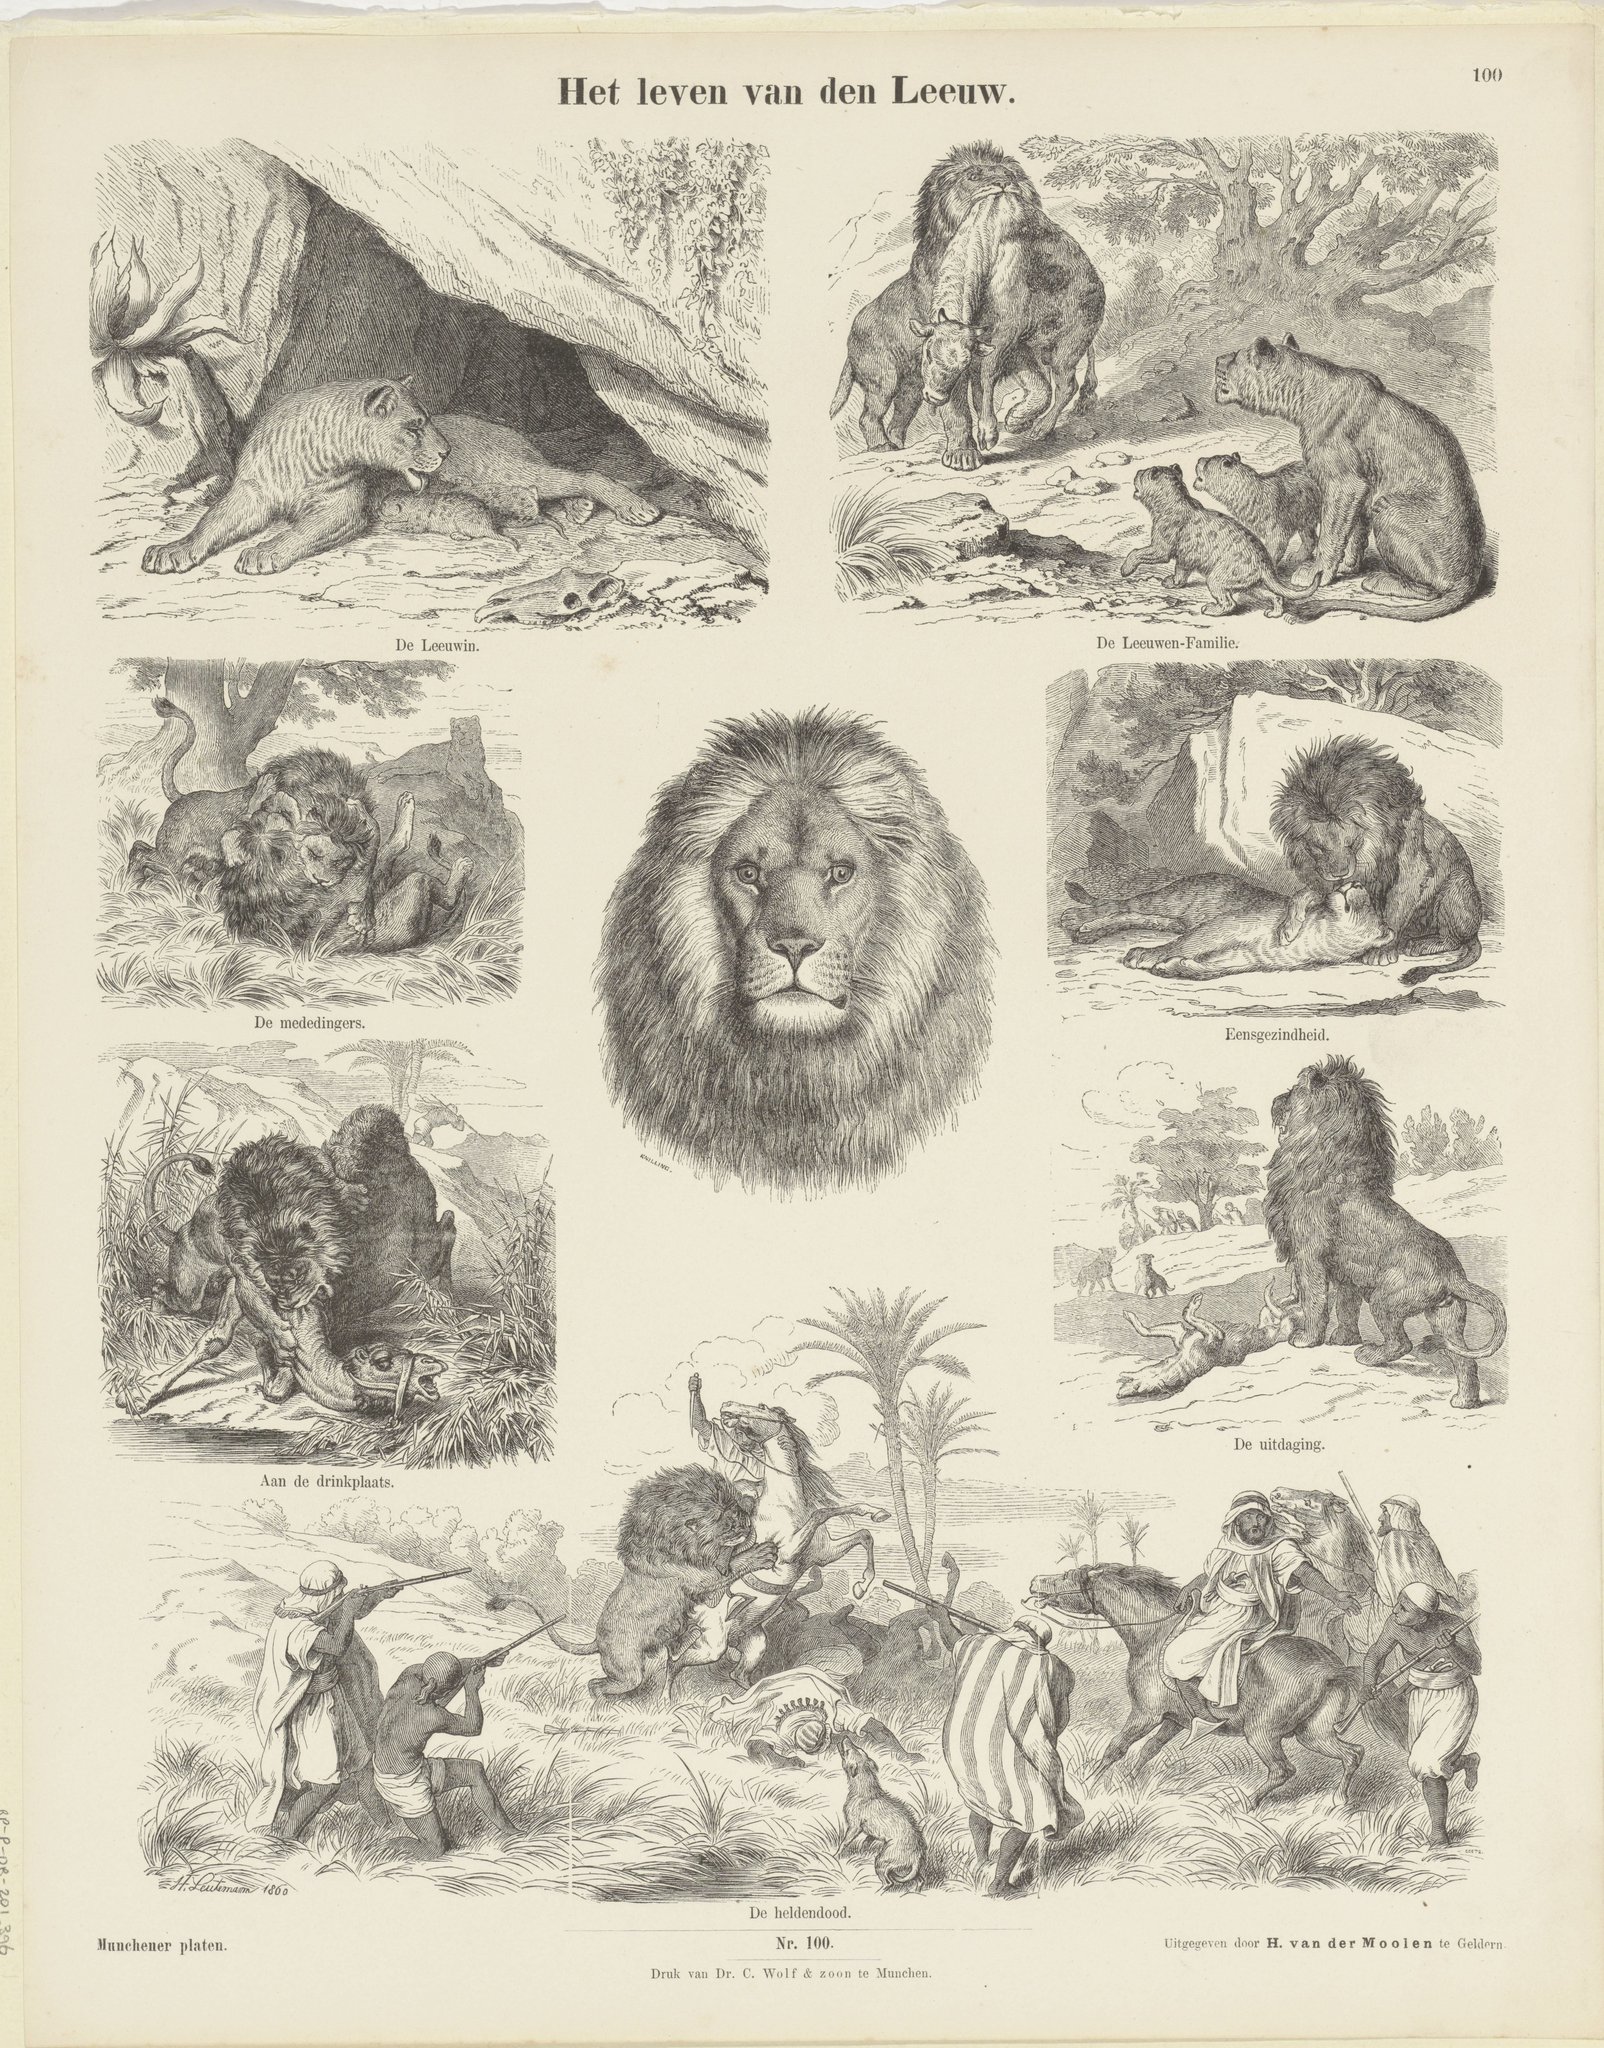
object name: print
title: Het leven van den leeuw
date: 1860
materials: paper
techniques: letterpress printing, engraving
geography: germany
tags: lion hunt, beasts of prey, predatory animals: lion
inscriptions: collector's mark: Lugt 2760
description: Blad met 8 voorstellingen over het leven van de leeuw met als slot een jachtscène. Onder elke afbeelding een onderschrift. Genummerd midden onder: Nro. 100. Genummerd rechtsboven: 100.